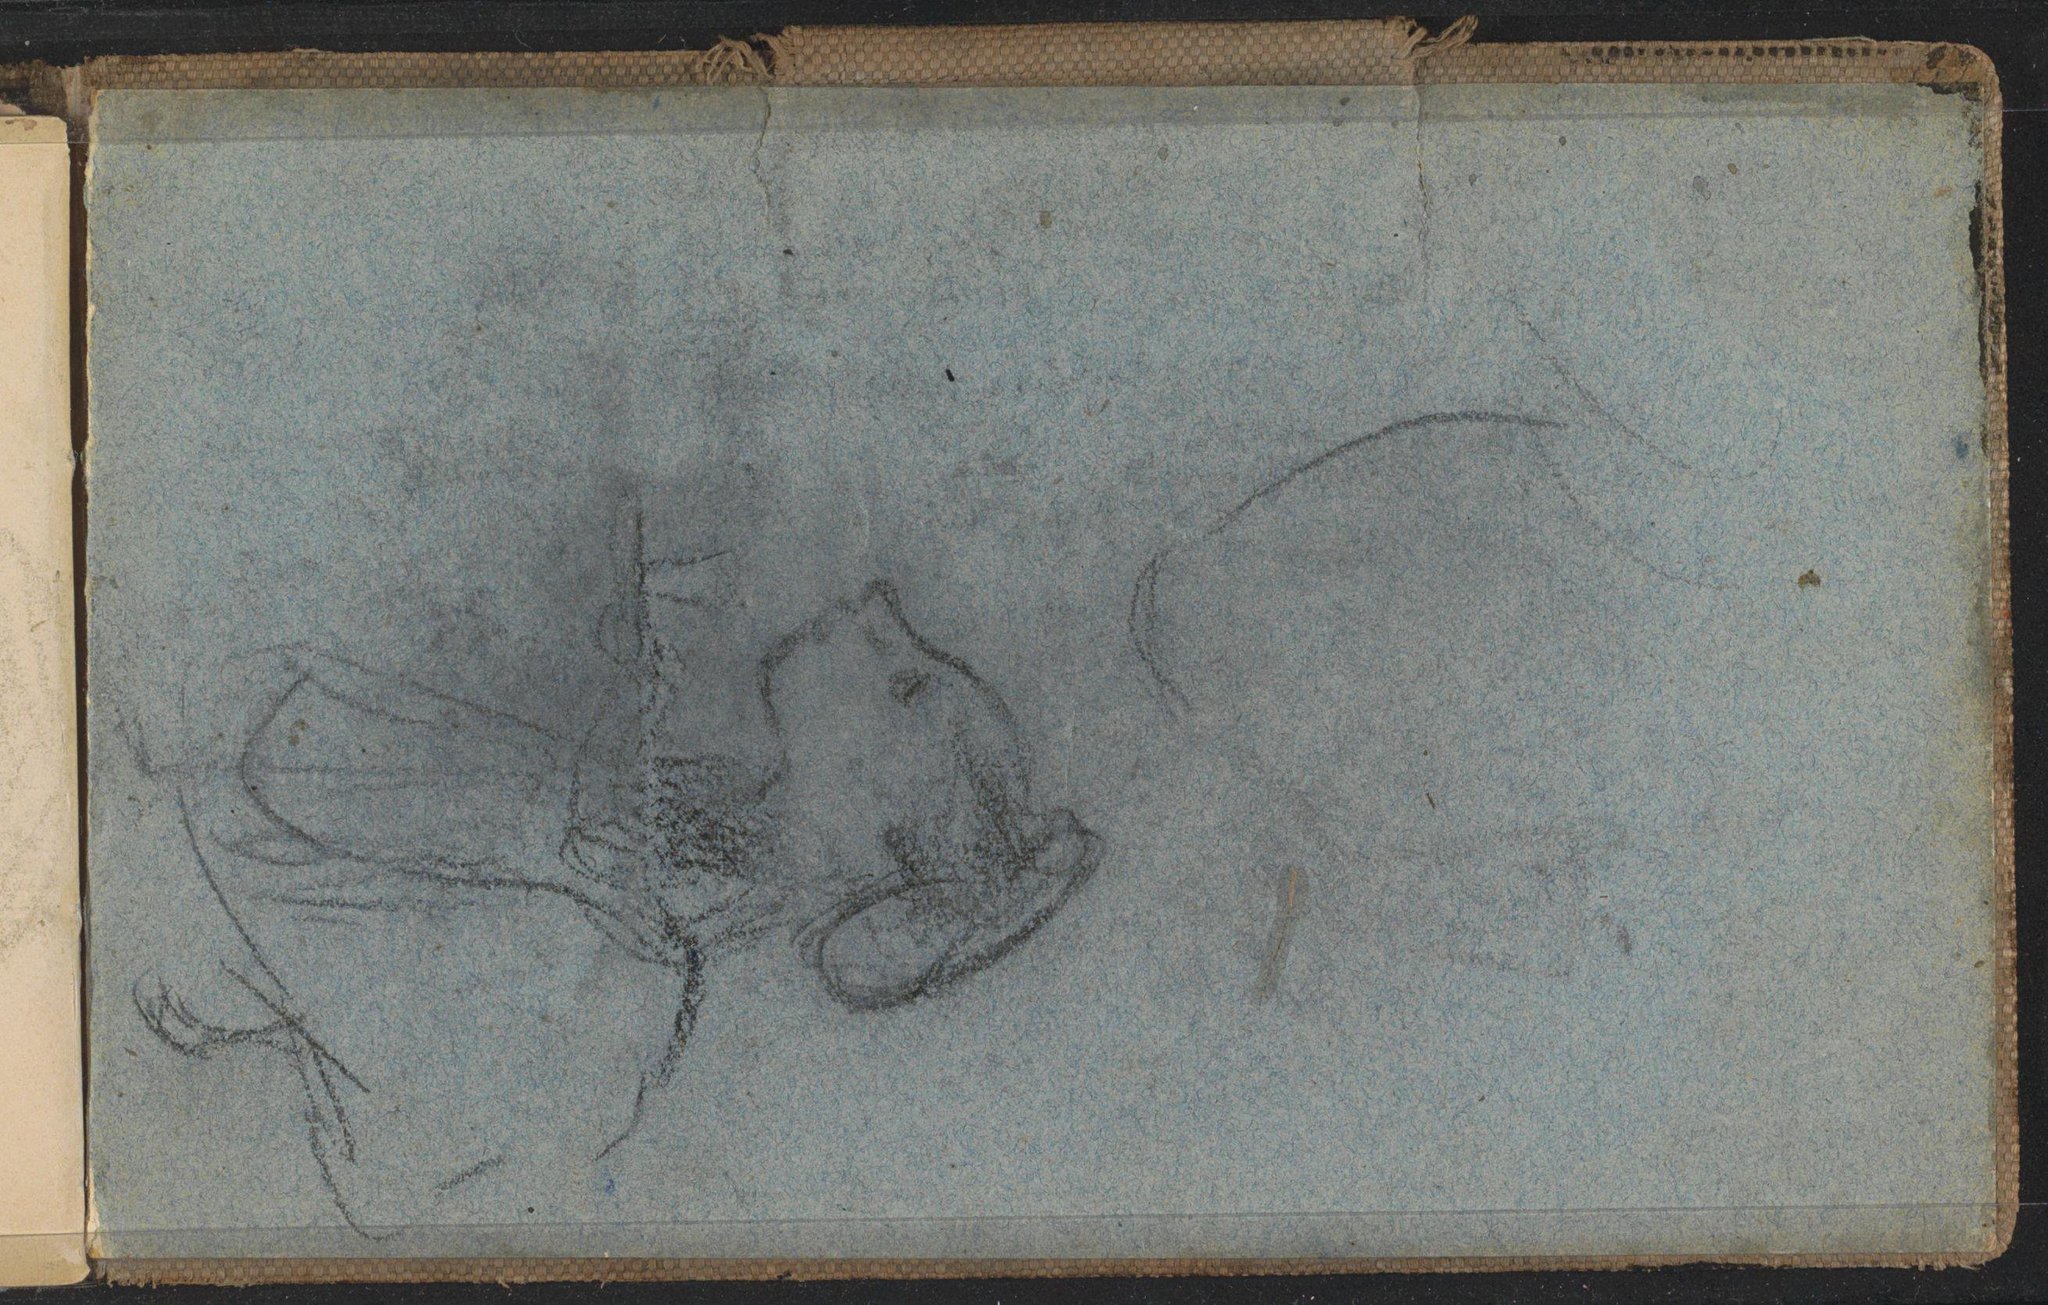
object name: sketchbook leaf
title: Kop van een vrouw met opgestoken haar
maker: jozef israëls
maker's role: draughtsman, painter, print maker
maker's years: 1824-1911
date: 1834-1911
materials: chalk, paper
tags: head (human) (+ female (human being) (not to be used where -aa- is prescribed))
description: Achterste schutblad uit een schetsboek met 42 bladen.